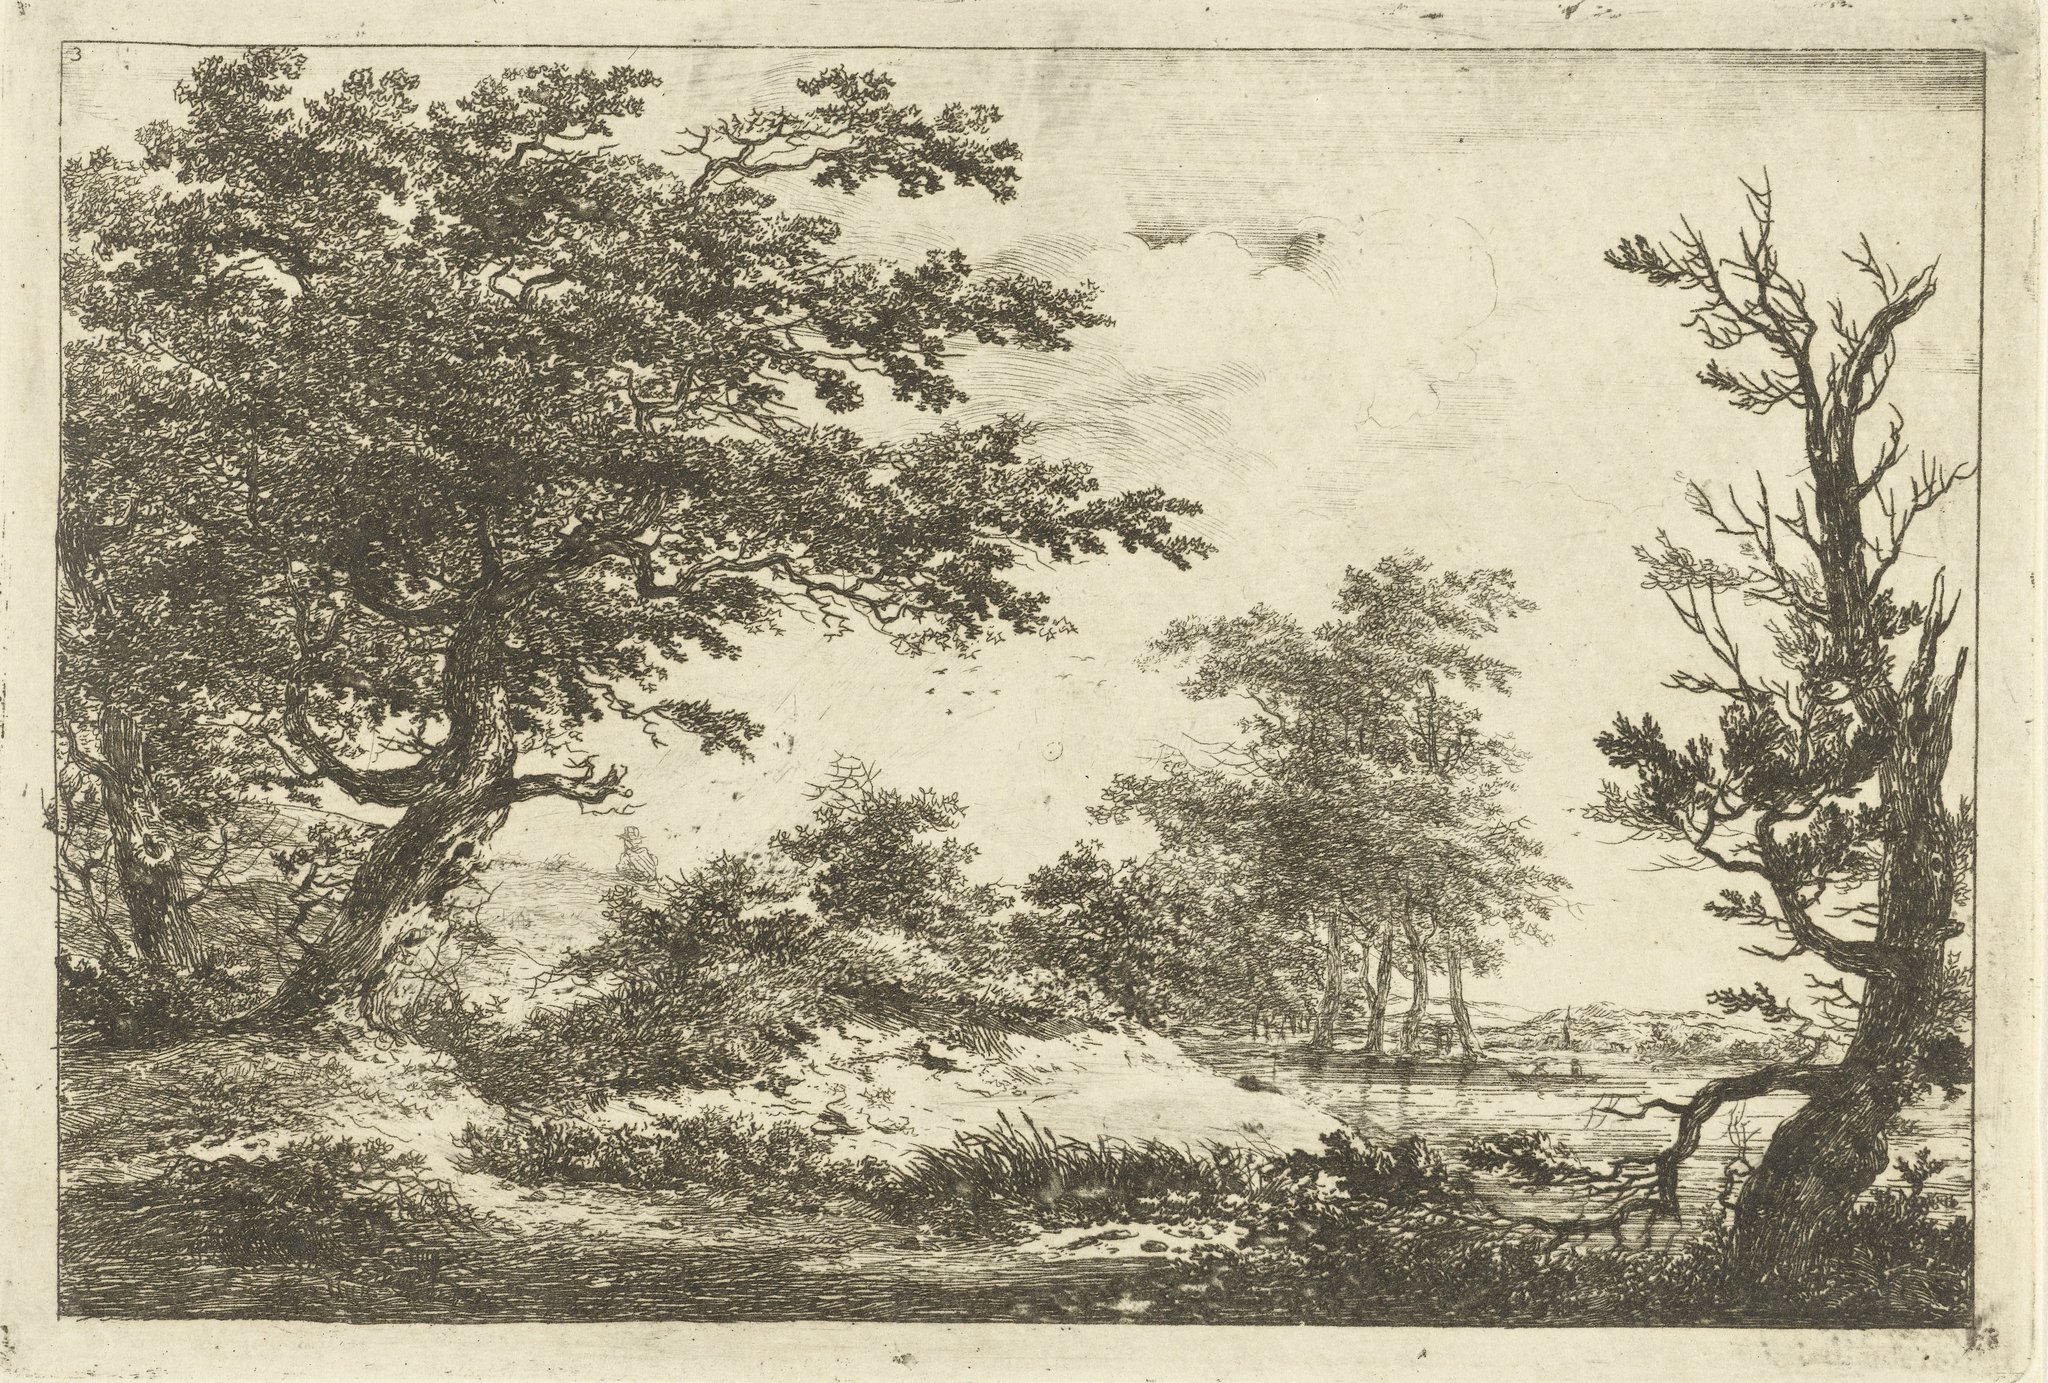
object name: print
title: Landschap met heuvel, water en bomen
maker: hermanus van brussel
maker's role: draughtsman, print maker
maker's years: 1763-1815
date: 1800-1815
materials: paper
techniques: etching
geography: netherlands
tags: forest, wood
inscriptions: collector's mark: Lugt 2228